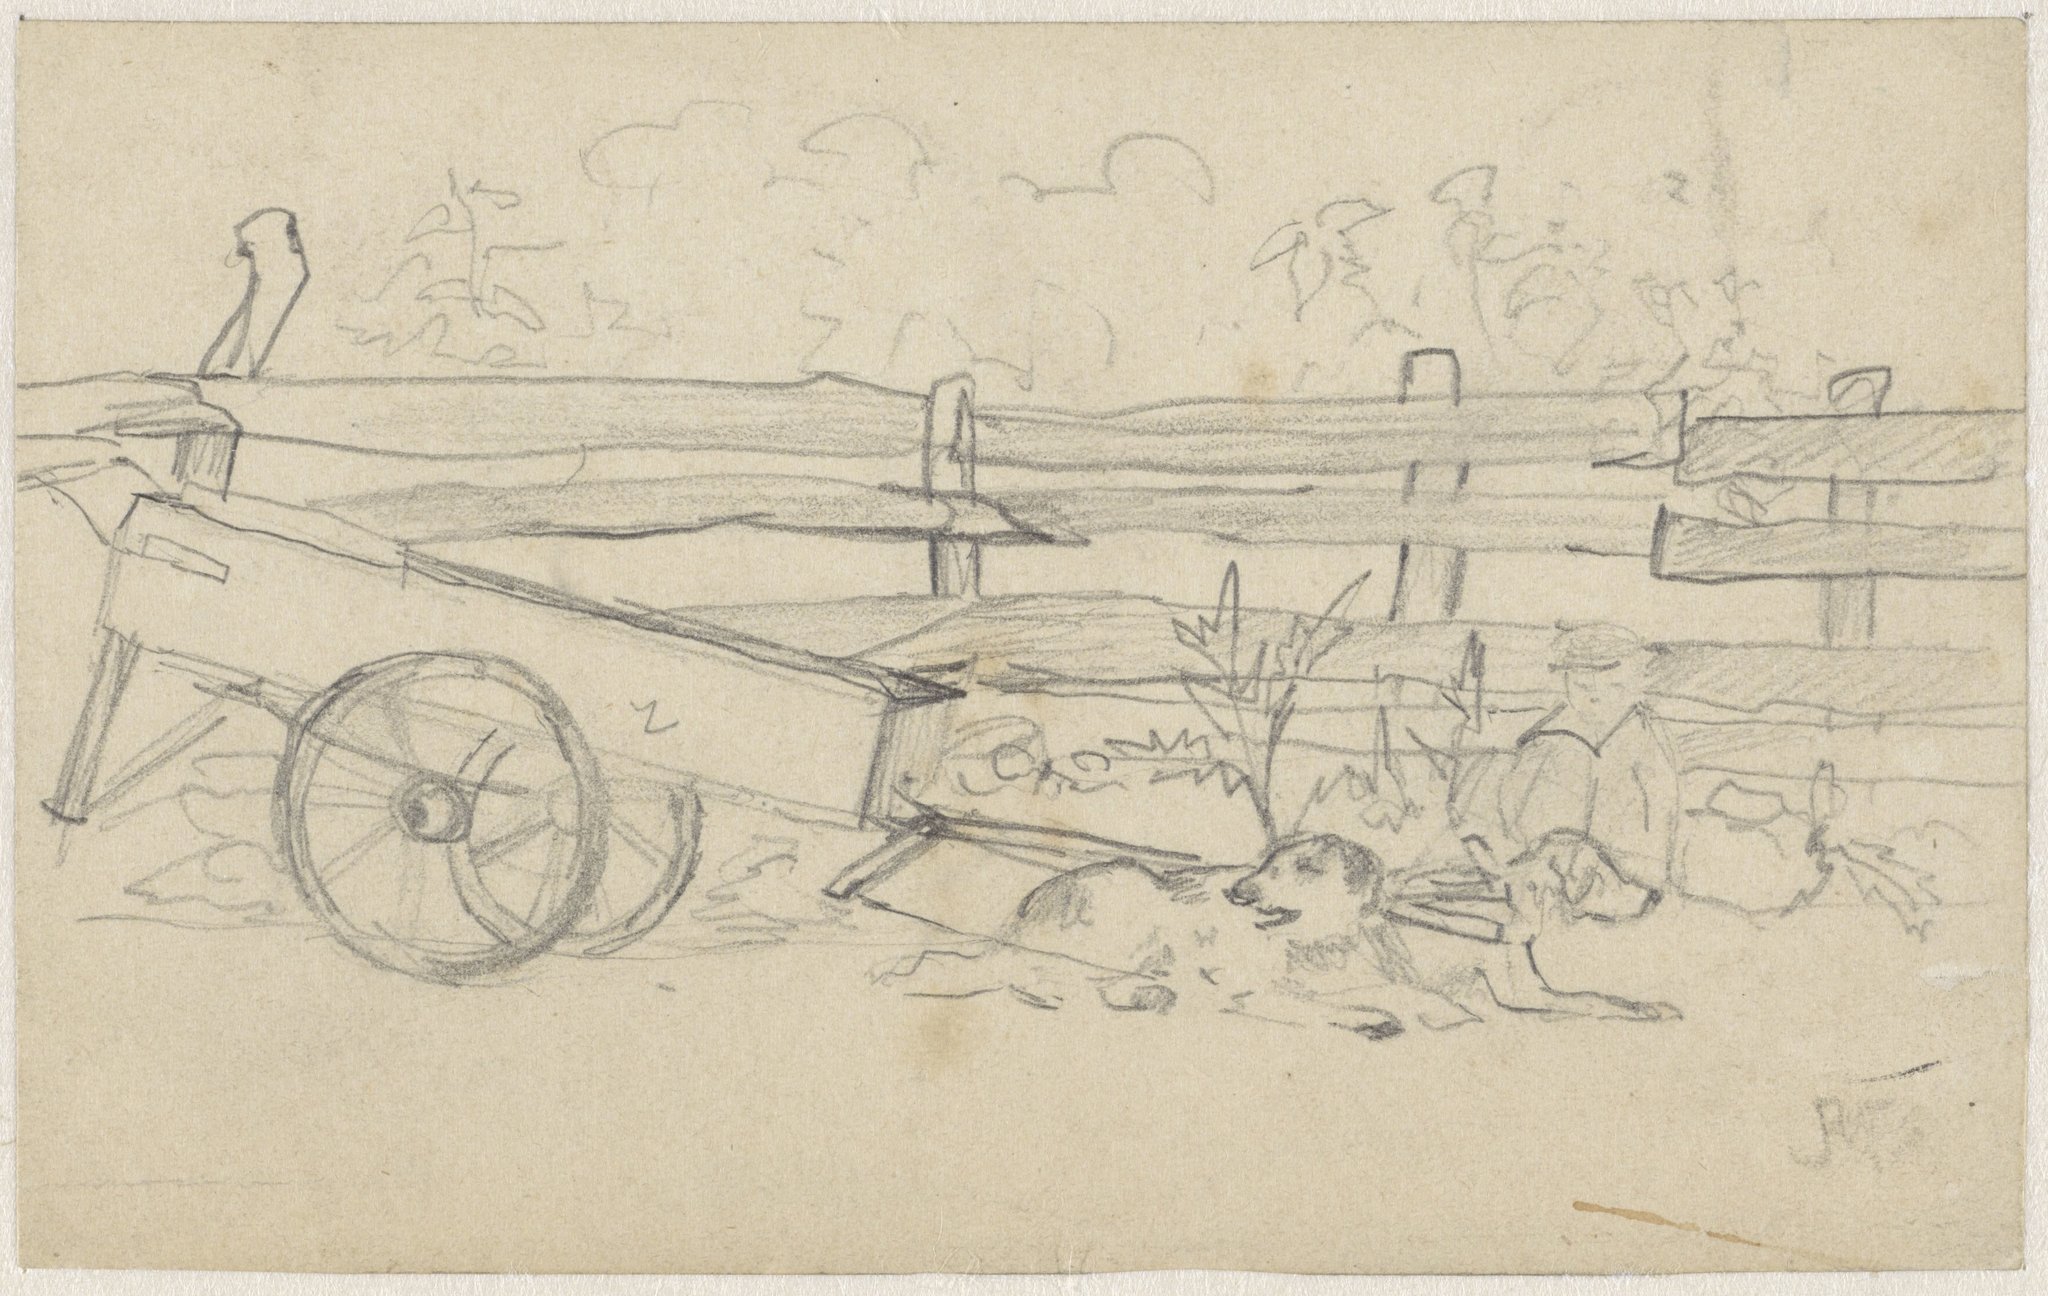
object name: drawing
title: Hondenkar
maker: johannes abraham mondt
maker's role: draughtsman, print maker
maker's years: 1859-1941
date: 1869-1941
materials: paper, pencil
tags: animal traction, animal-drawn vehicle (carriage etc.), dog